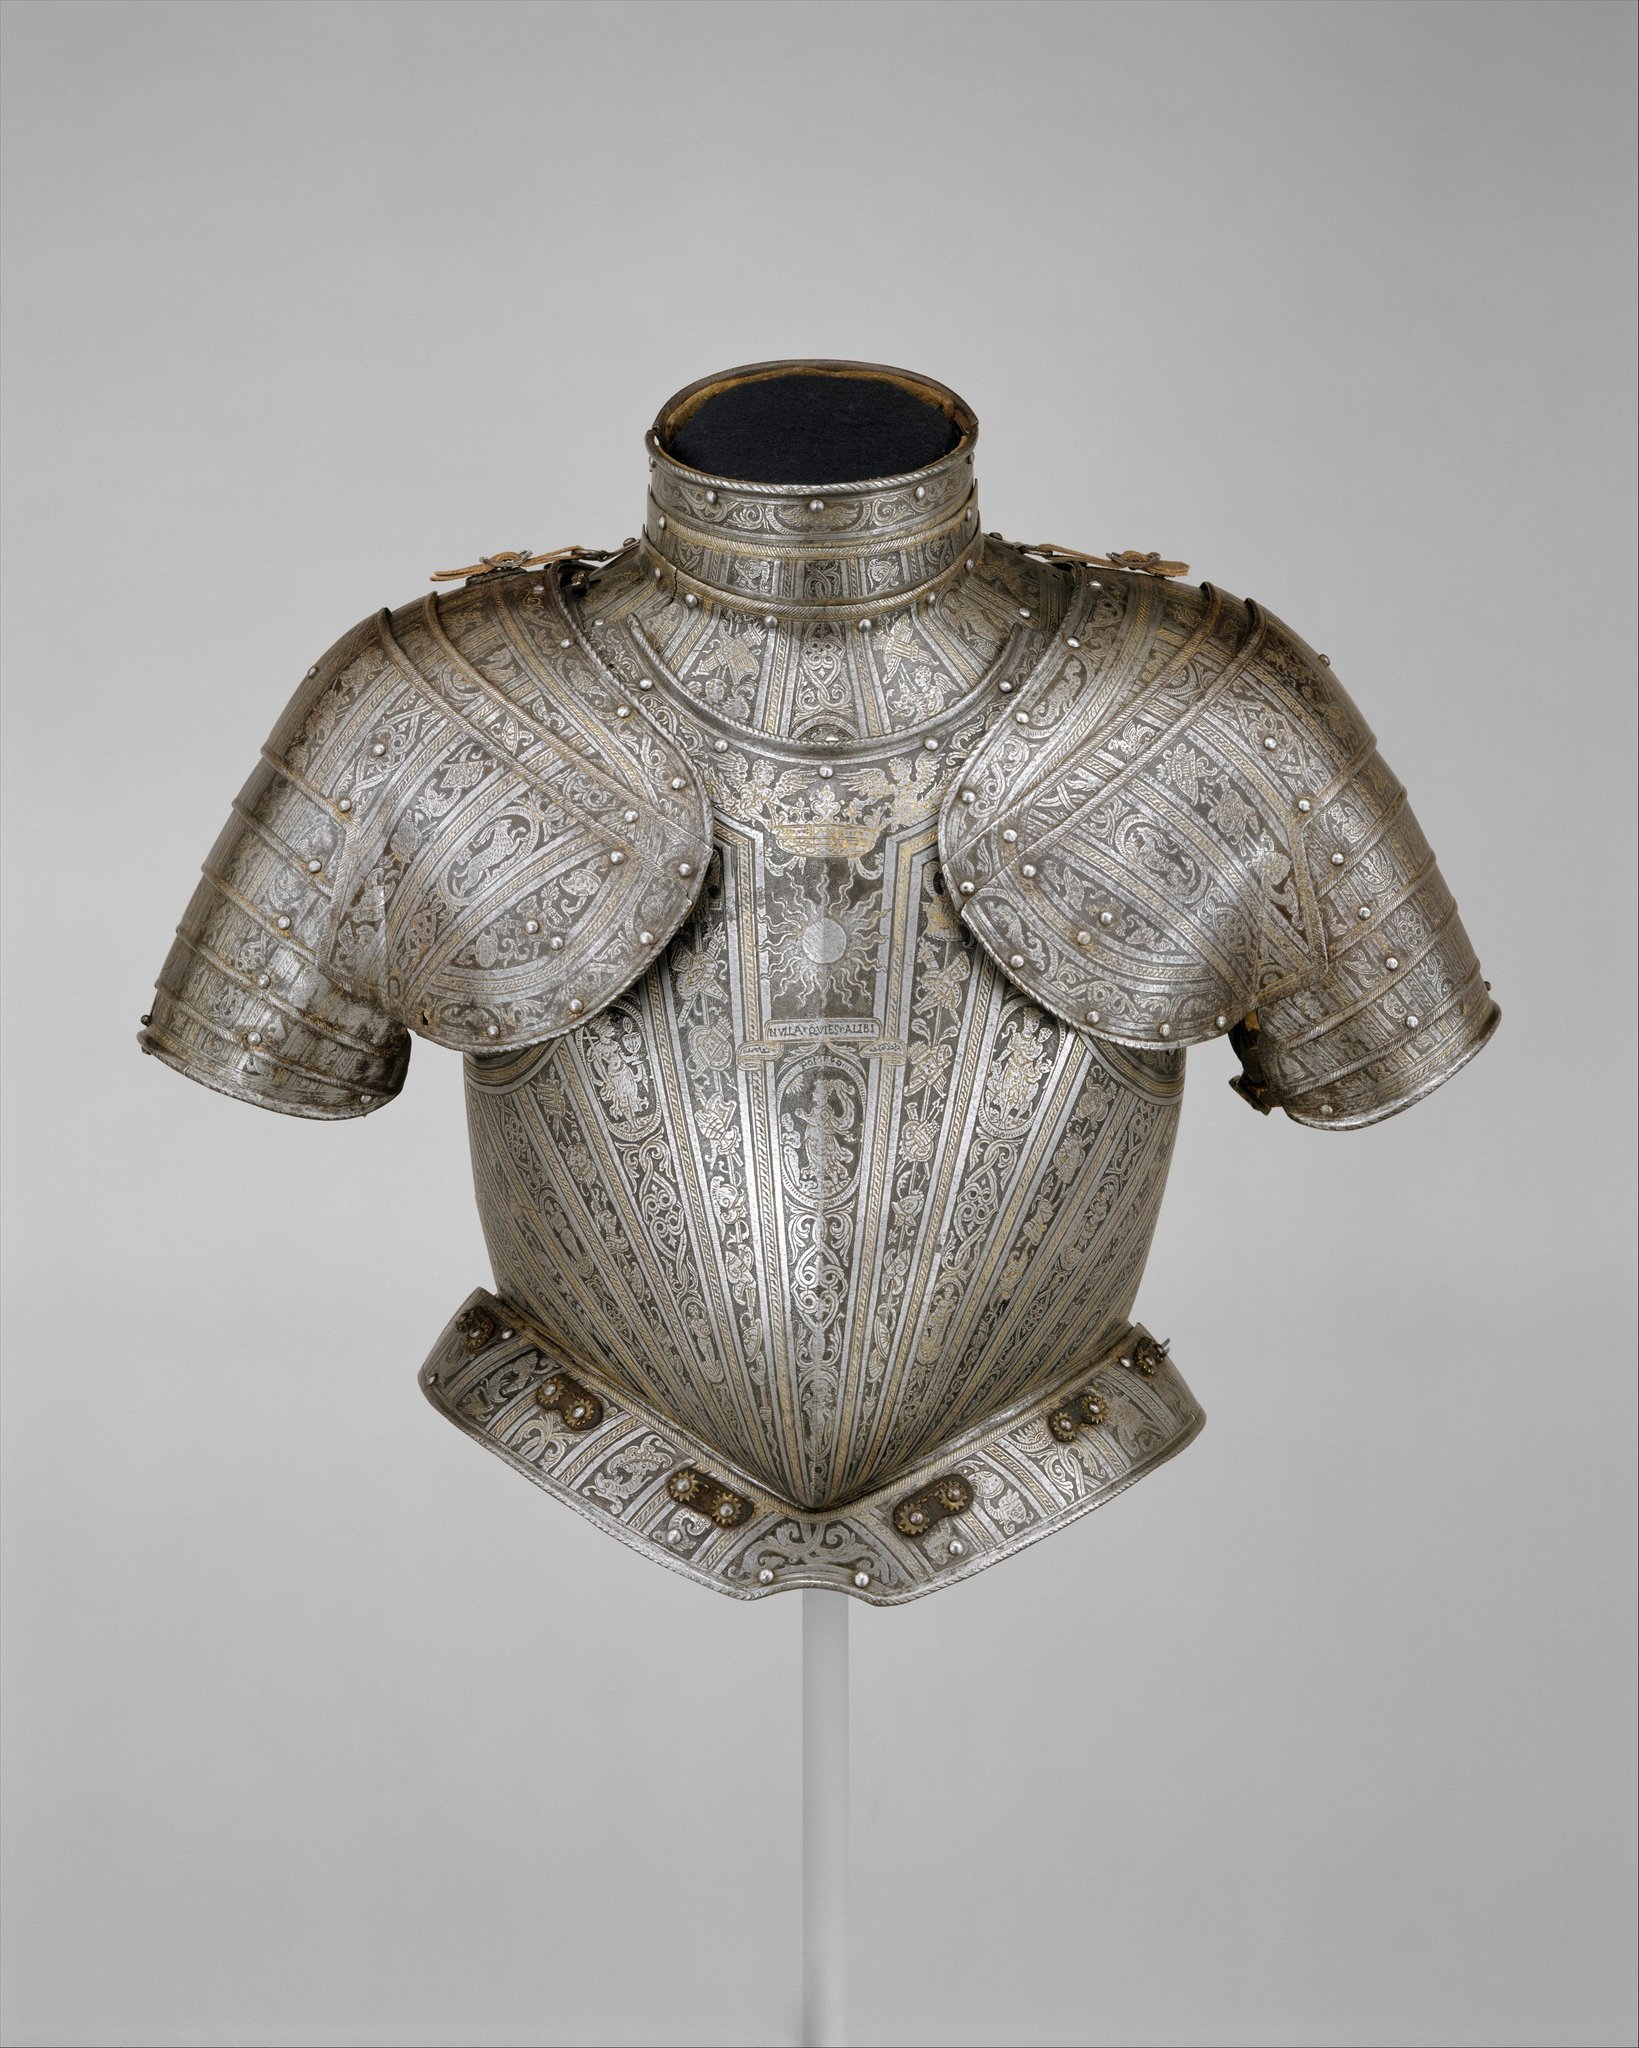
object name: portion of an armor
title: Portions of an Armor for Vincenzo Luigi di Capua (d. 1627)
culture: italian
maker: pompeo della cesa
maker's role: armorer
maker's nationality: italian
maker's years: 1512-1635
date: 1595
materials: copper alloy, gold, leather, steel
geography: italy